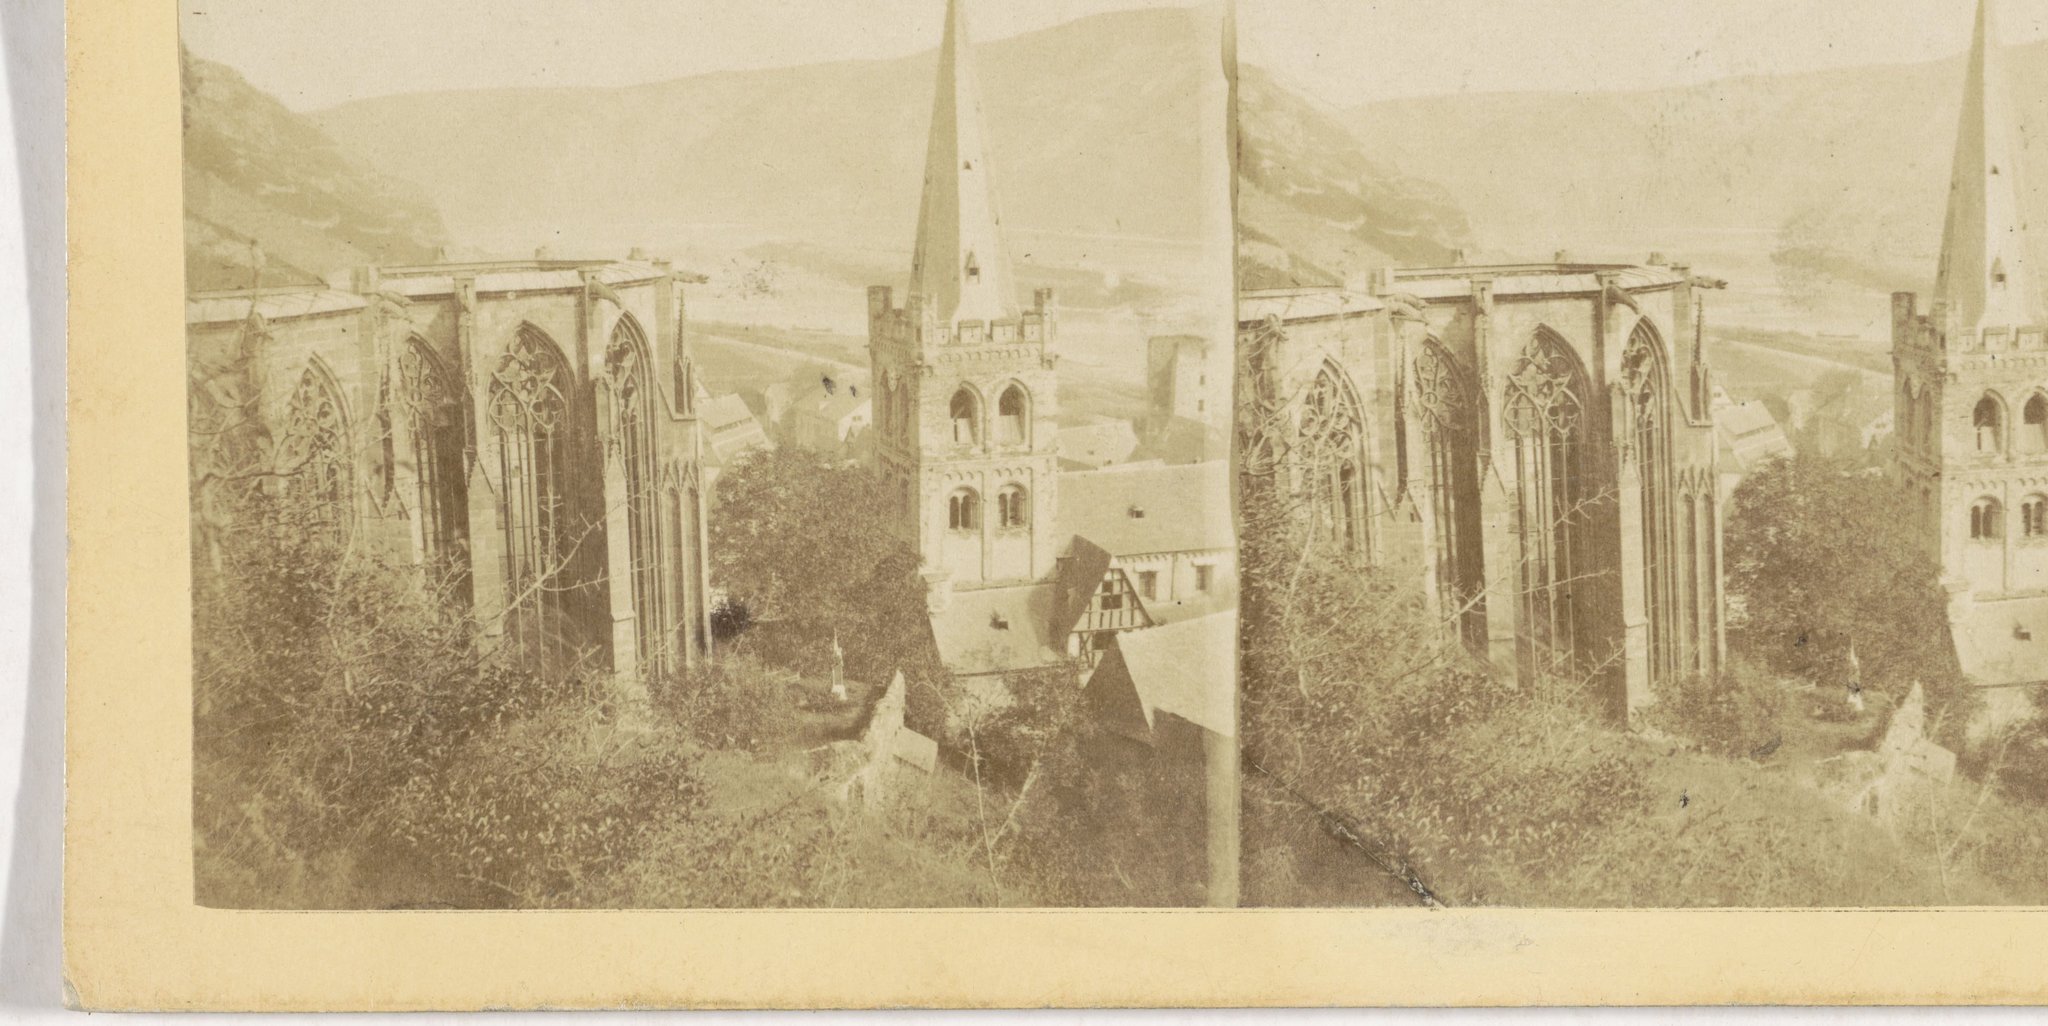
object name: stereograph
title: Ruïne van de Wernerkapel en de Sint Pieterskerk in Bacharach, Duitsland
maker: Anonymous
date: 1861-1870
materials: cardboard, paper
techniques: albumen print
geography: bacharach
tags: ruin of church, monastery, etc., parts of church exterior and annexes: tower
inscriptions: inscription: ‘110’, number: ‘No 85’, inscription: ‘152’, inscription: ‘152’